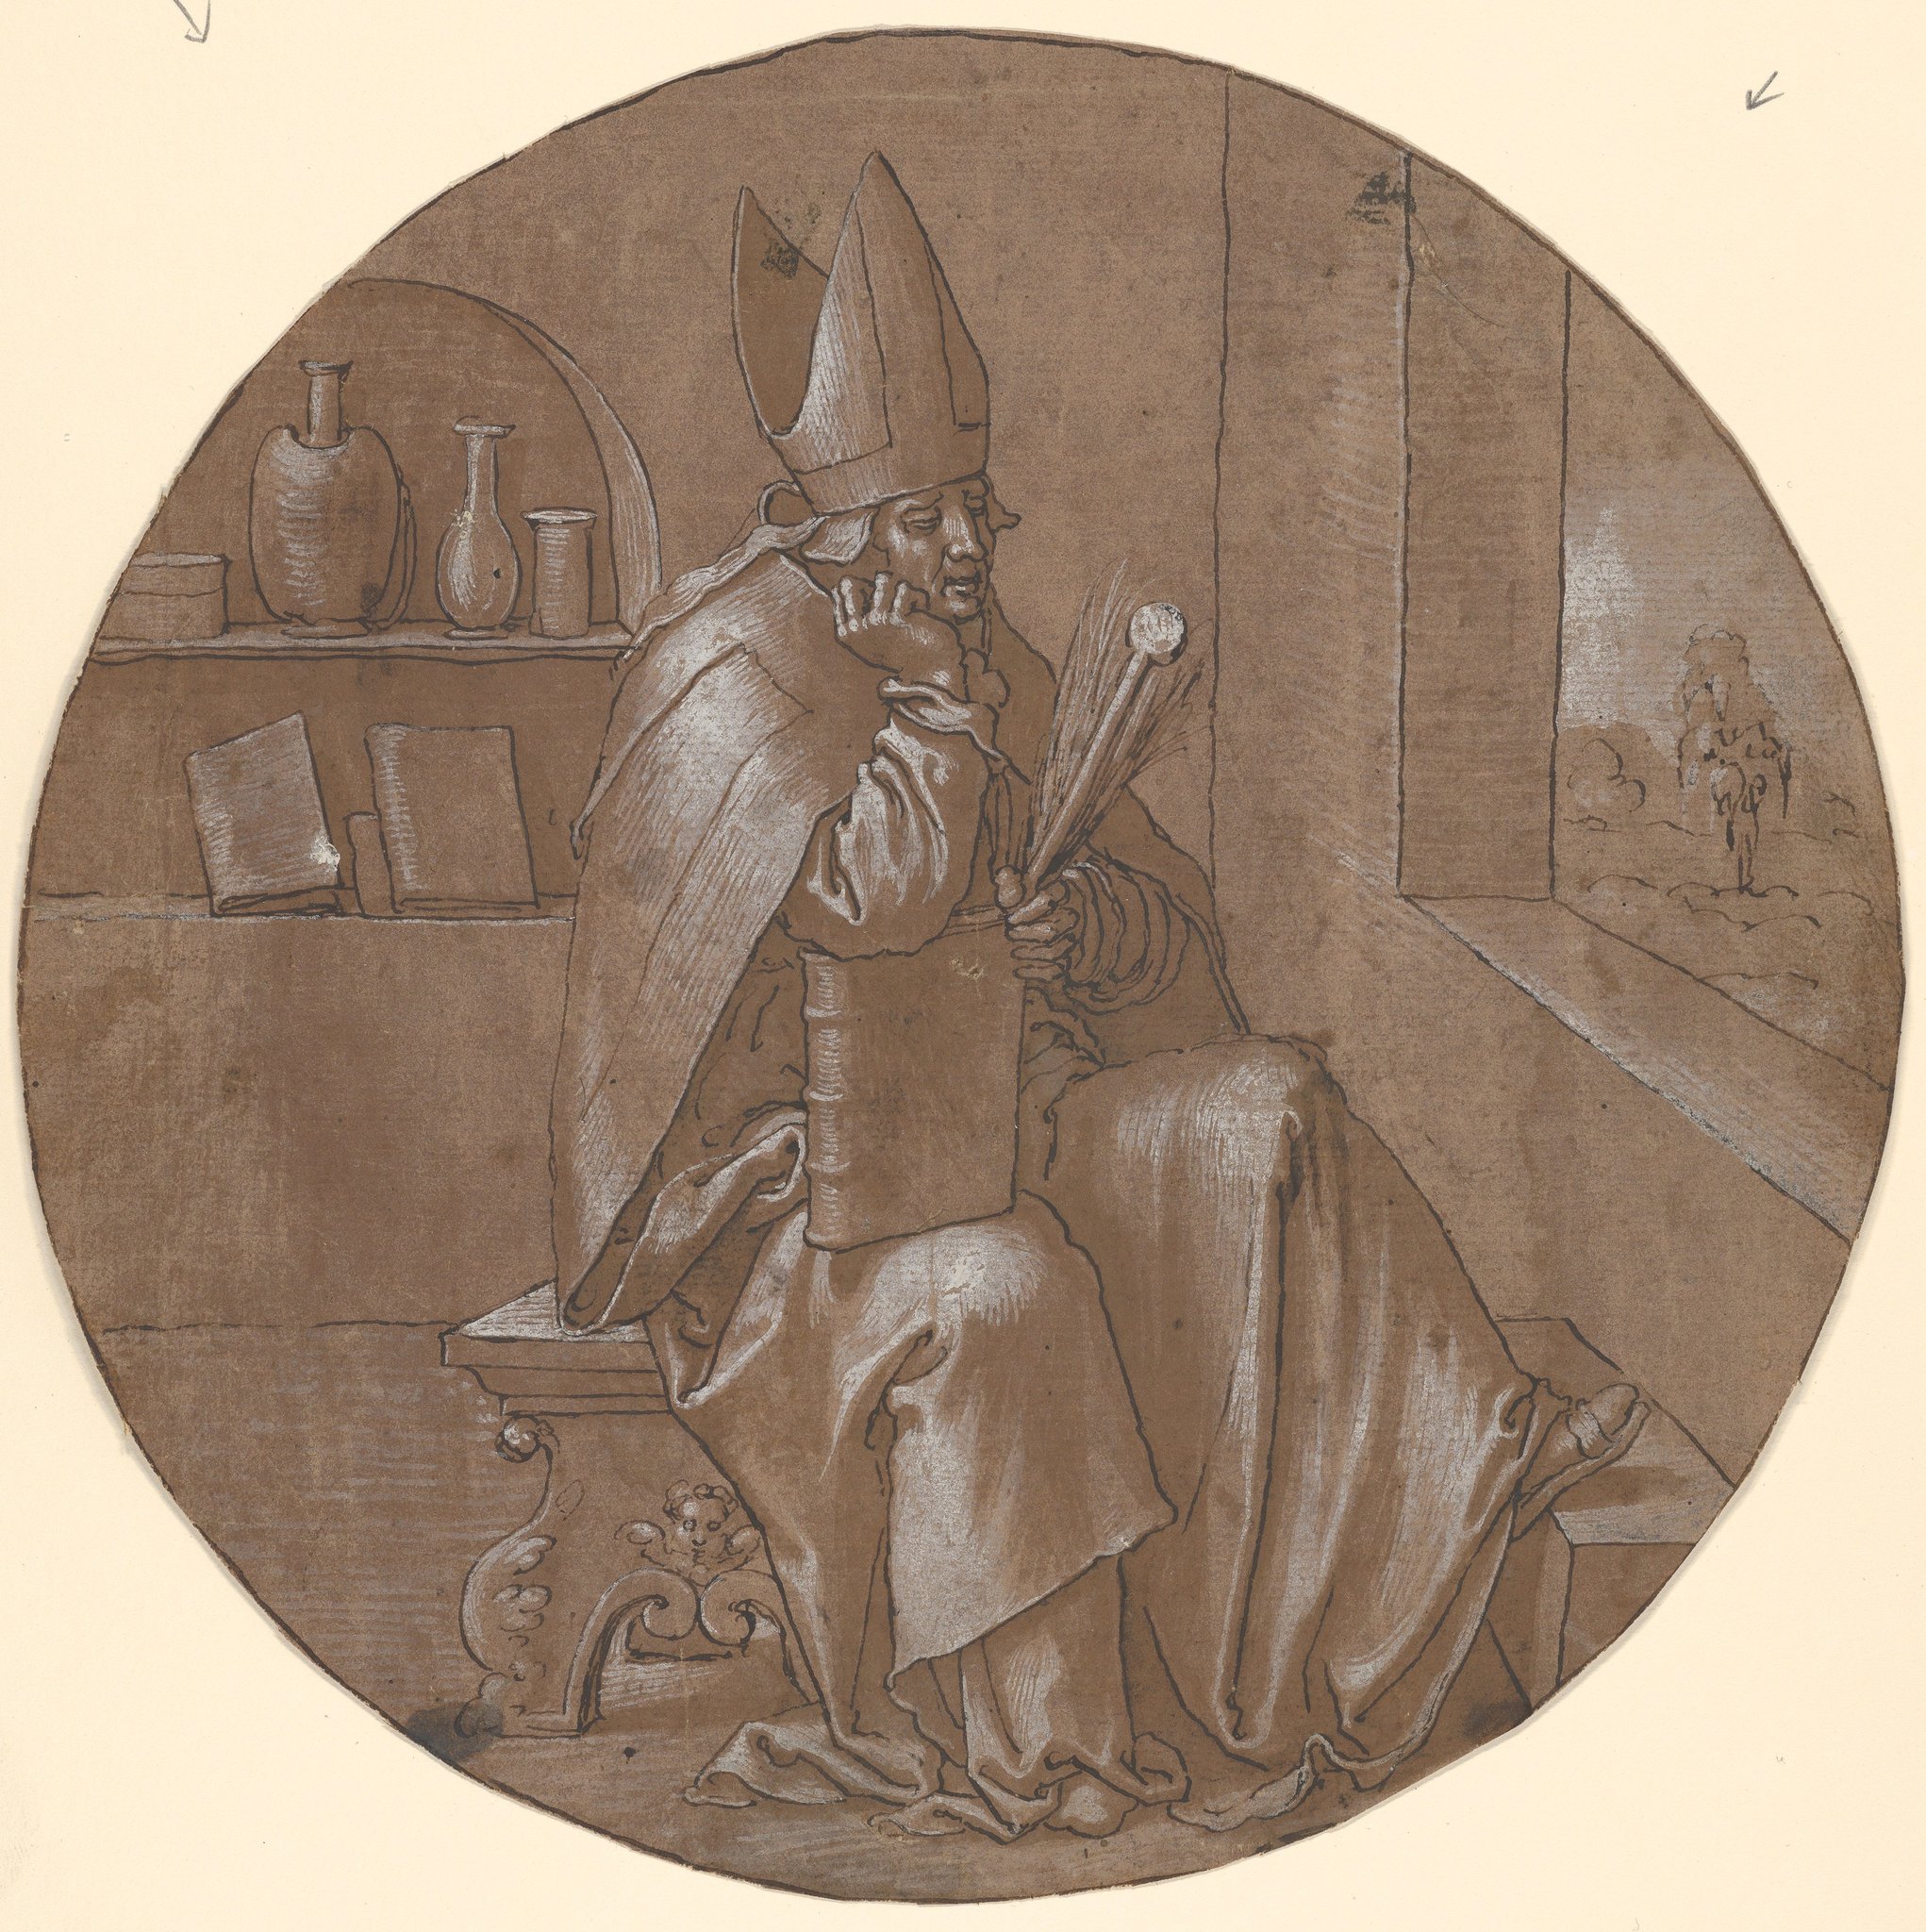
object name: drawing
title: Saint Ambrose Seated in an Interior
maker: anonymous, netherlandish, 16th century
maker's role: artist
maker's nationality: netherlandish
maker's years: 1500-1600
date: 1520-1540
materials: gouache, ink, paper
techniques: heightening, pen, wash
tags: interiors,contemplation,men,saints